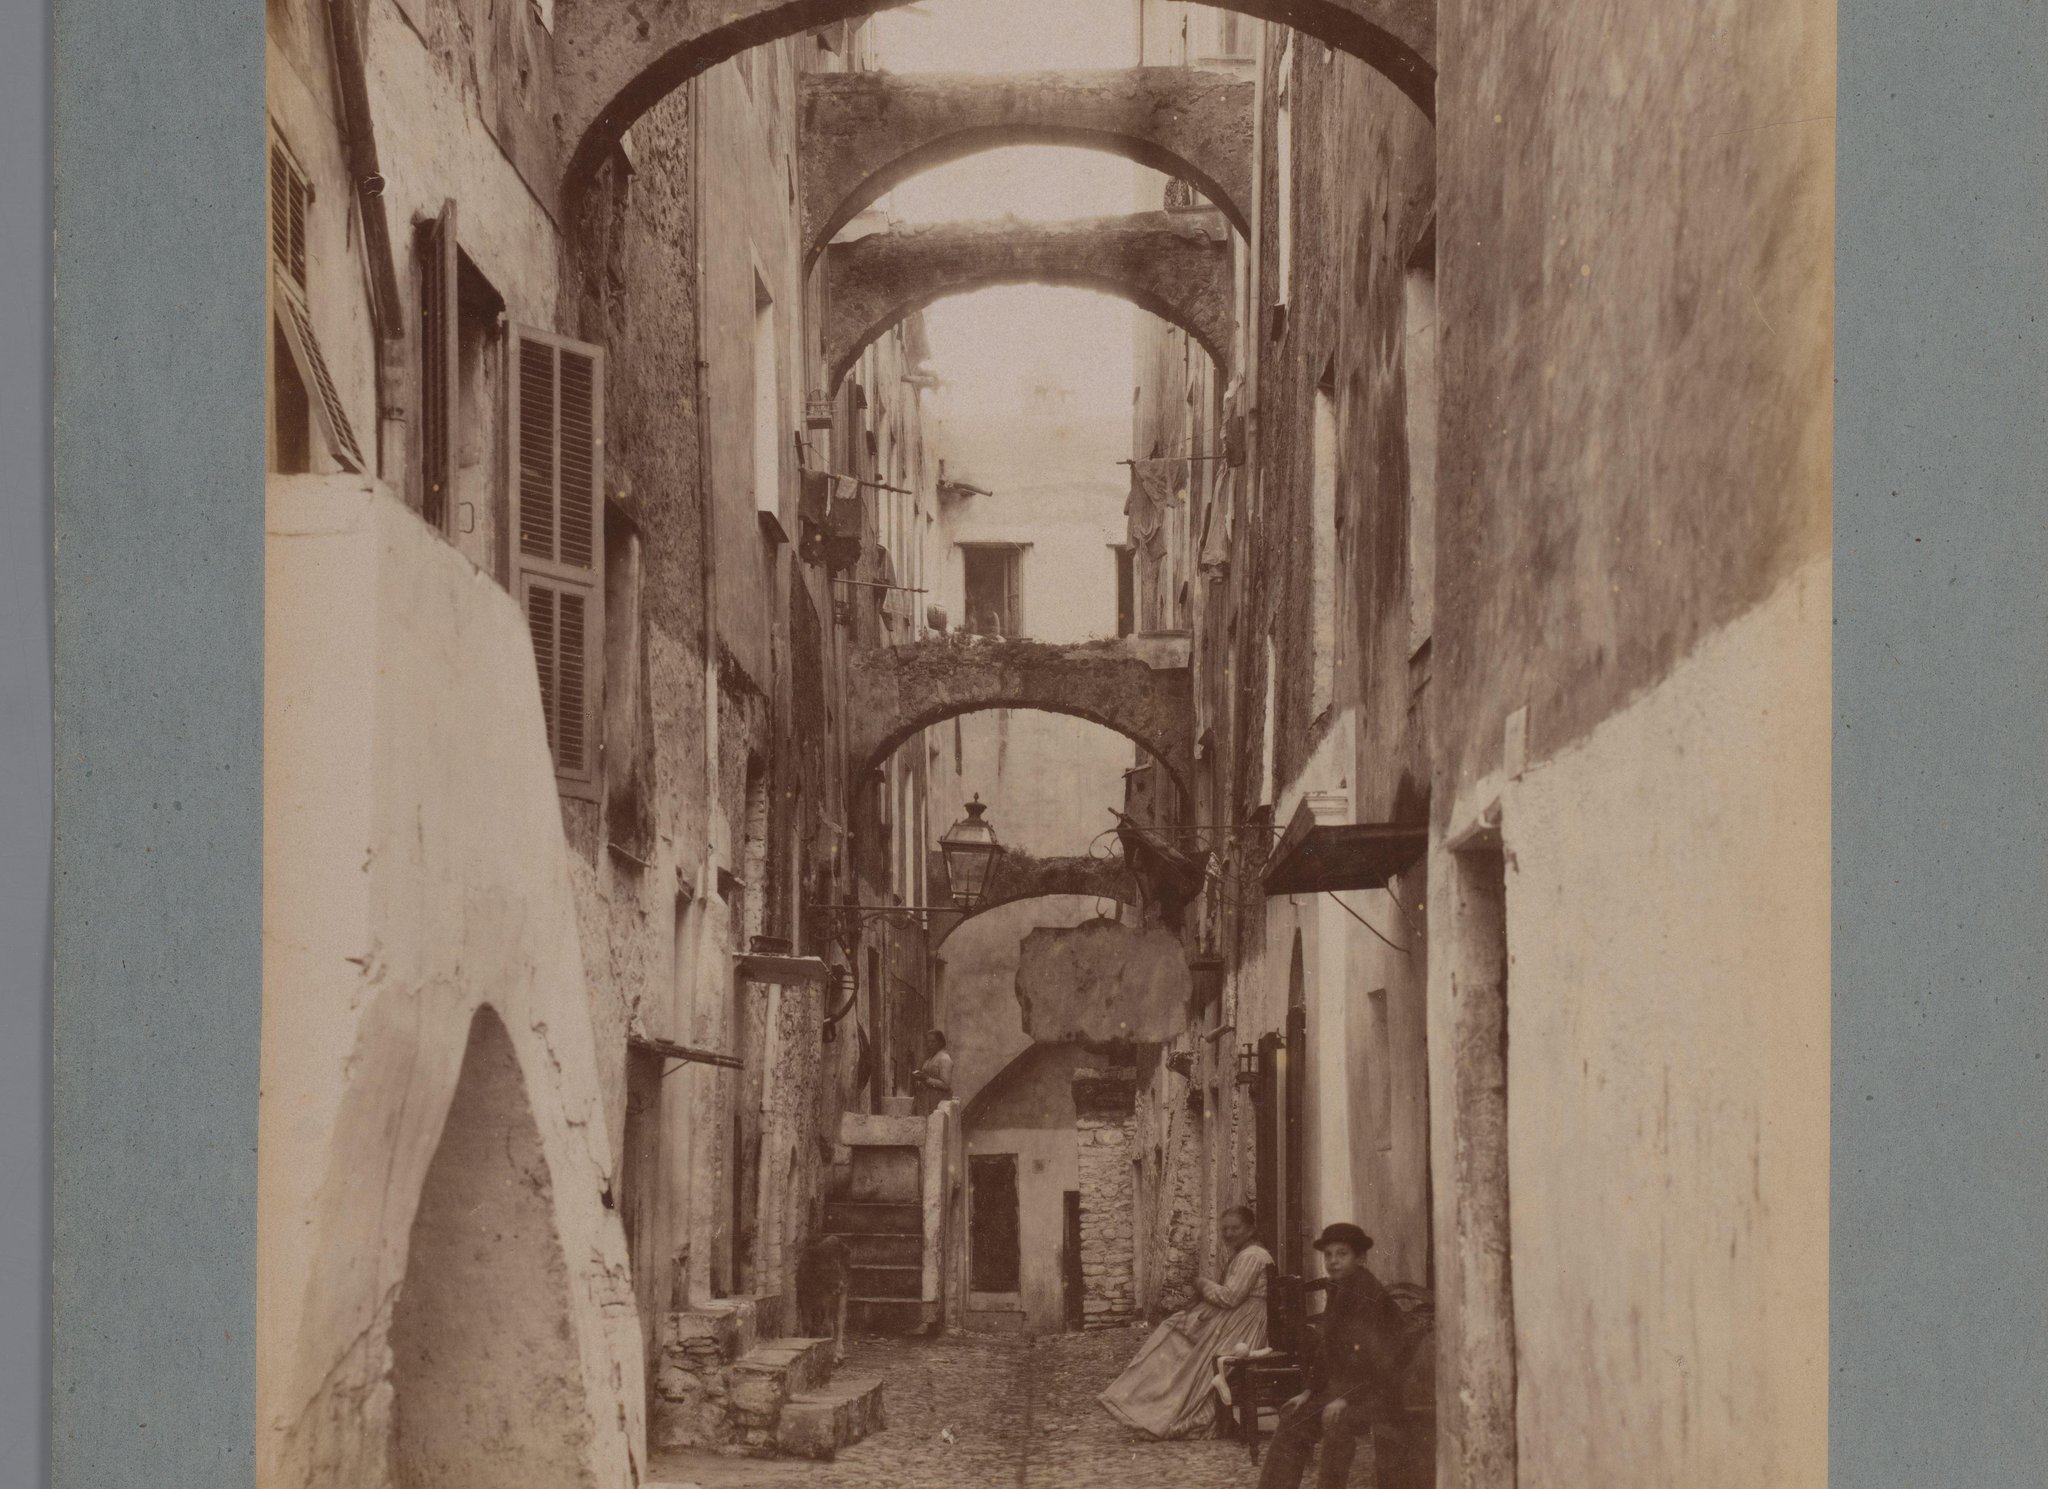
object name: photograph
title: Vicolo del Giuoco della Palla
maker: giacomo brogi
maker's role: fotograaf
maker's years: 1822-1881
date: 1864-1881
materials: cardboard, paper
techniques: albumen print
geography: florence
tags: street, public road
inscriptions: number: ‘8091.’, collector's mark: ‘VOSMAER’